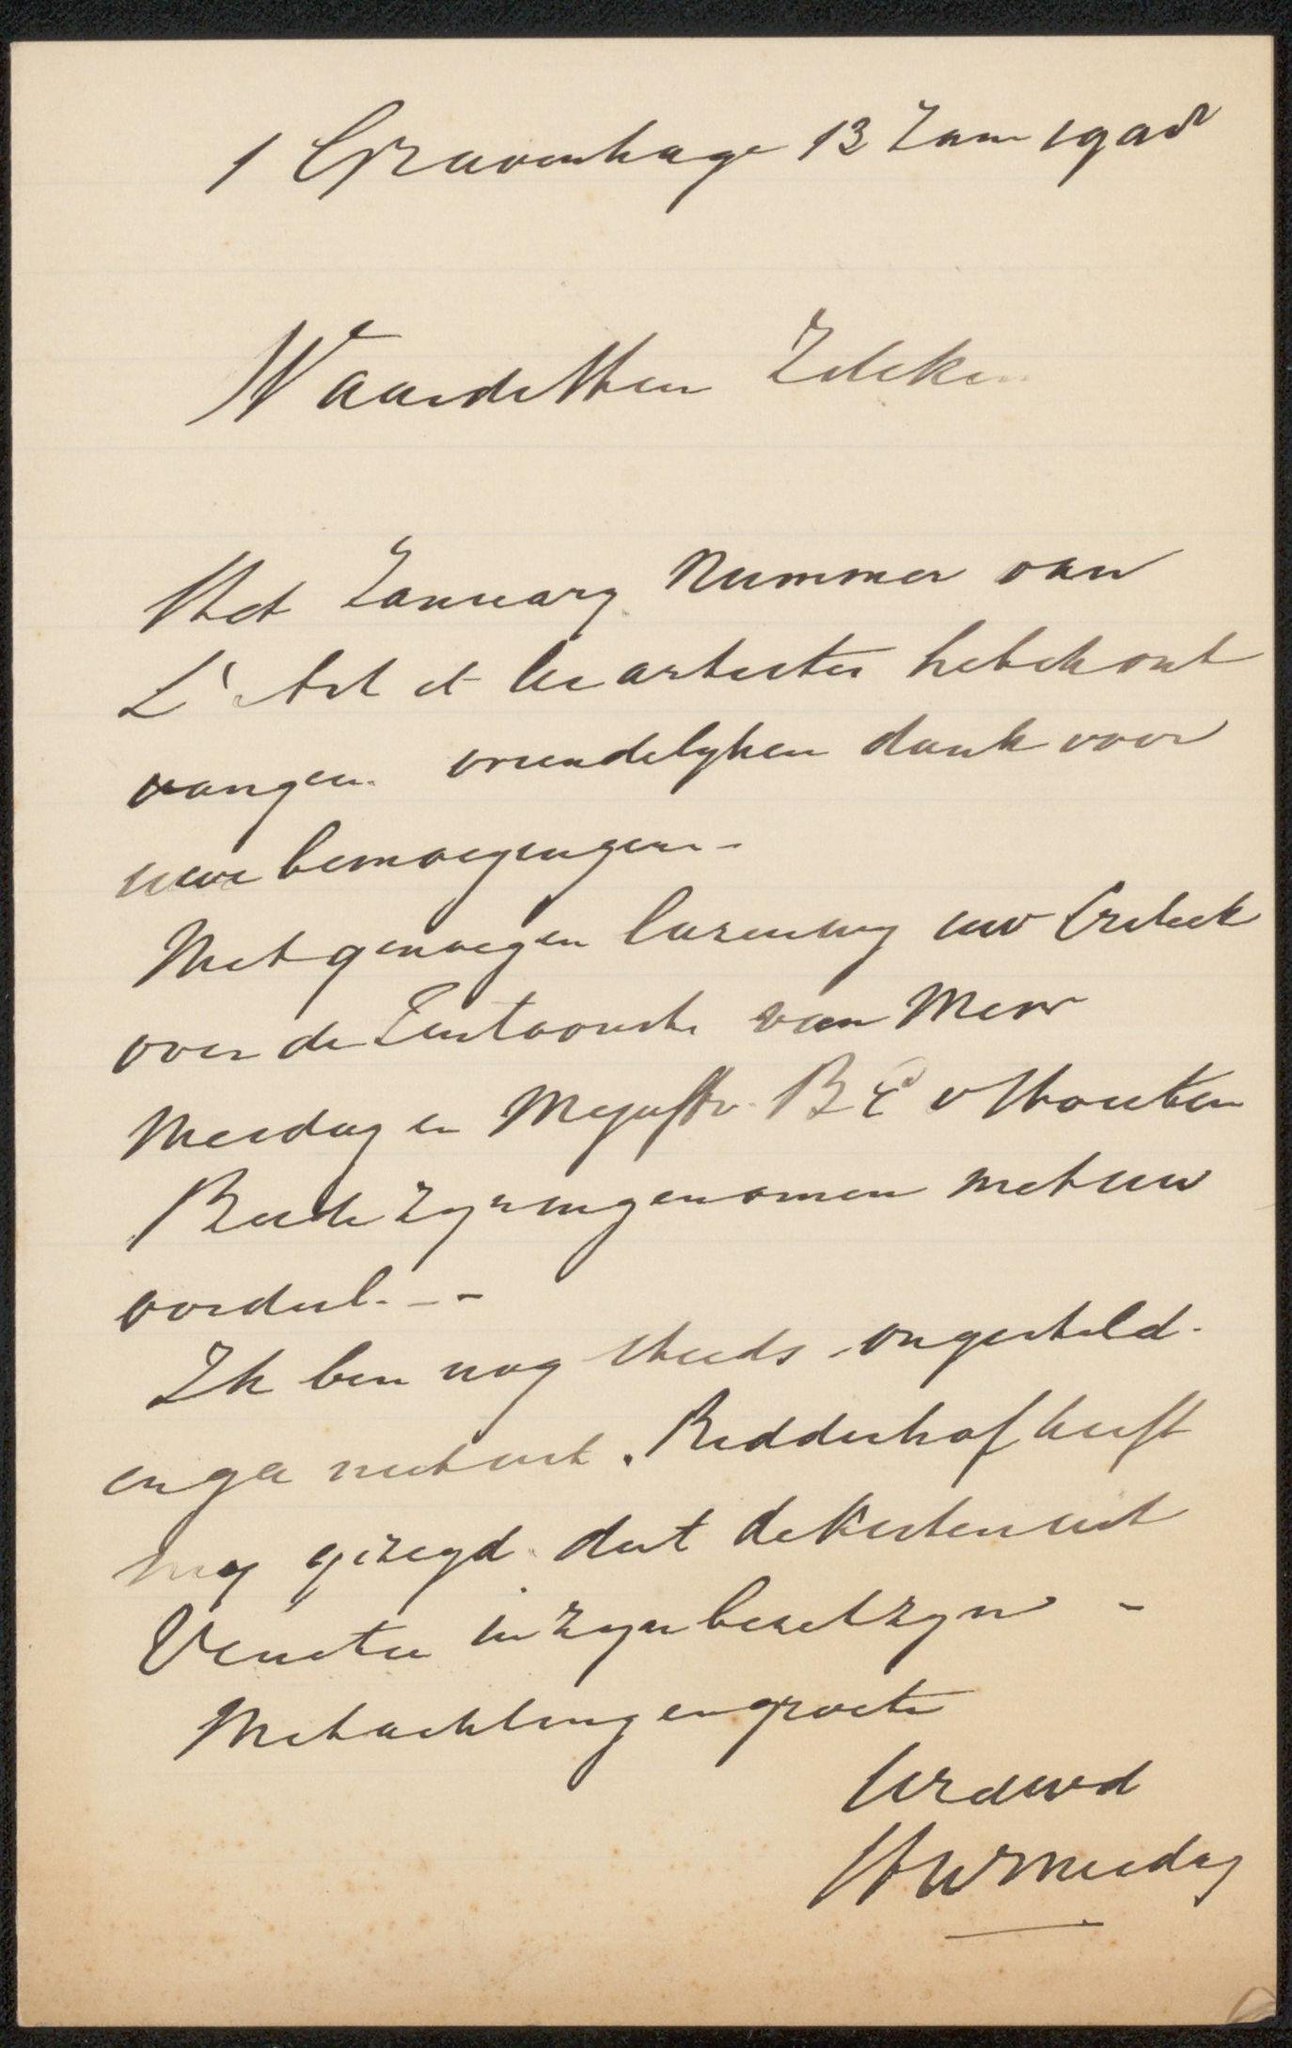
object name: letter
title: Brief aan Philip Zilcken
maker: hendrik willem mesdag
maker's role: draughtsman, painter, print maker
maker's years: 1831-1915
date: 1908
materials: ink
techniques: pen, writing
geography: the hague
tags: print maker, barbara elisabeth van houten, sientje mesdag-van houten, the hague, painter, draughtsman, philip zilcken, exhibition ~ art, diseases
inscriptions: collector's mark: ‘RPK’